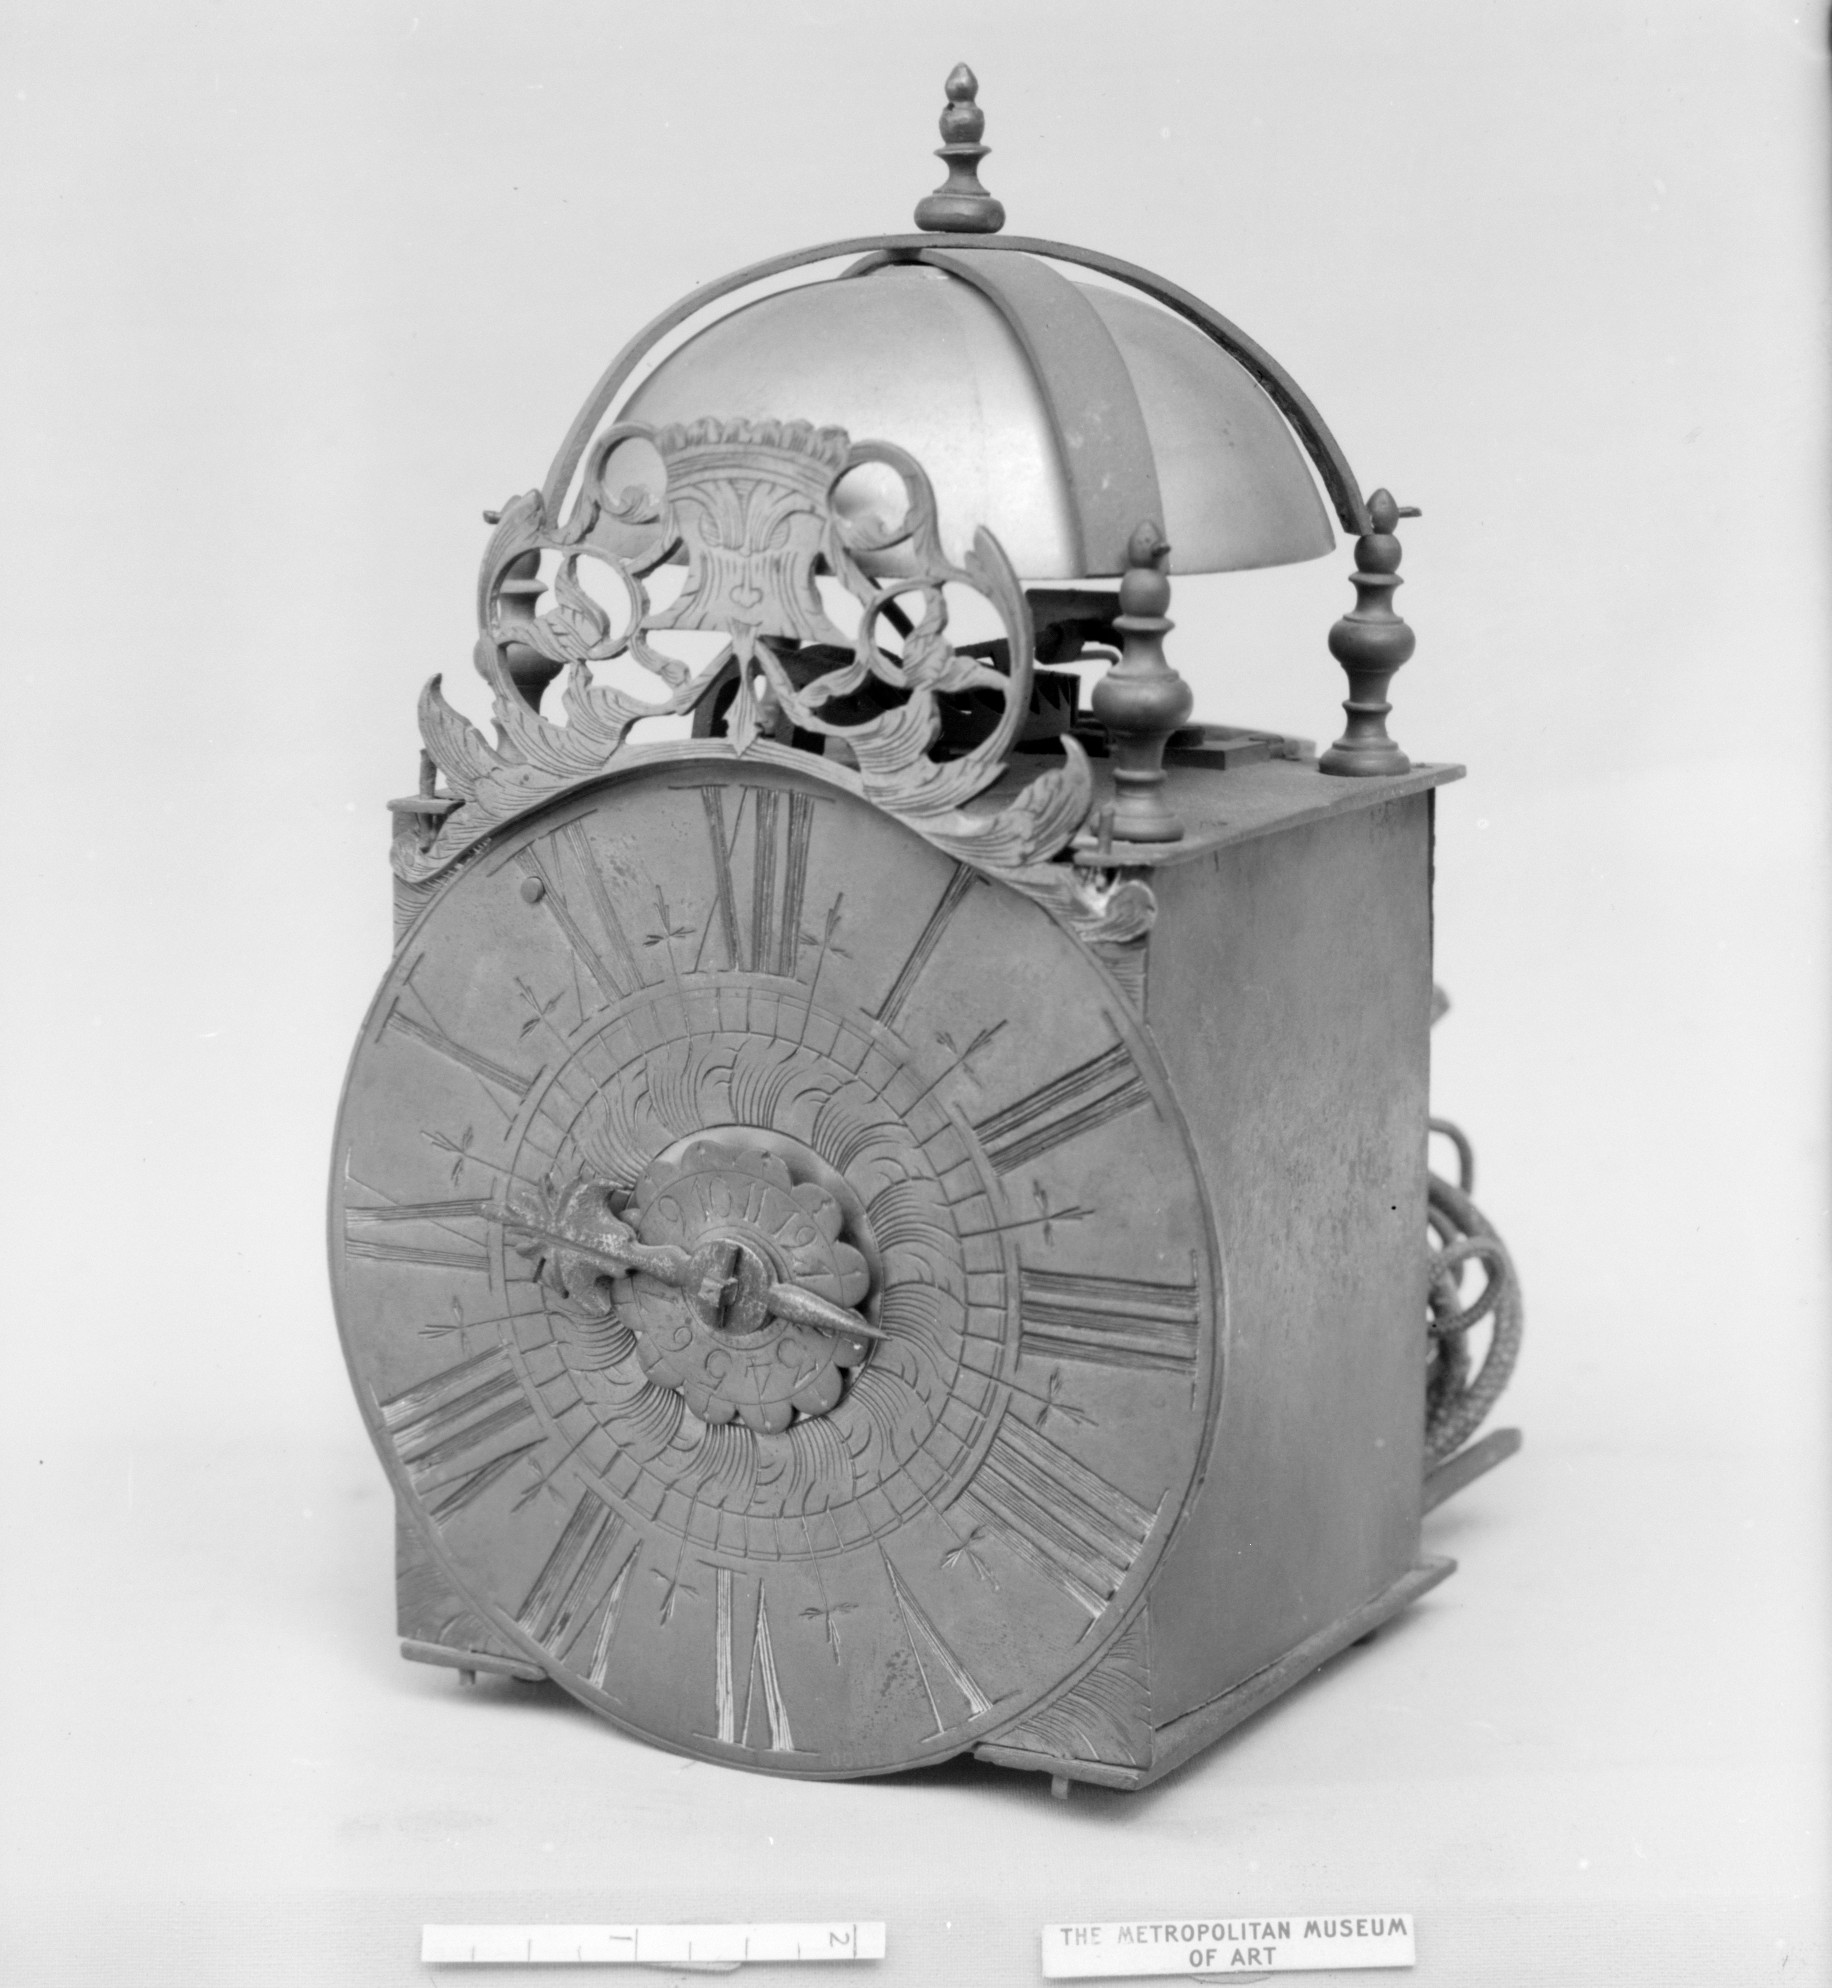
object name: lantern clock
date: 1701-1733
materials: brass, steel